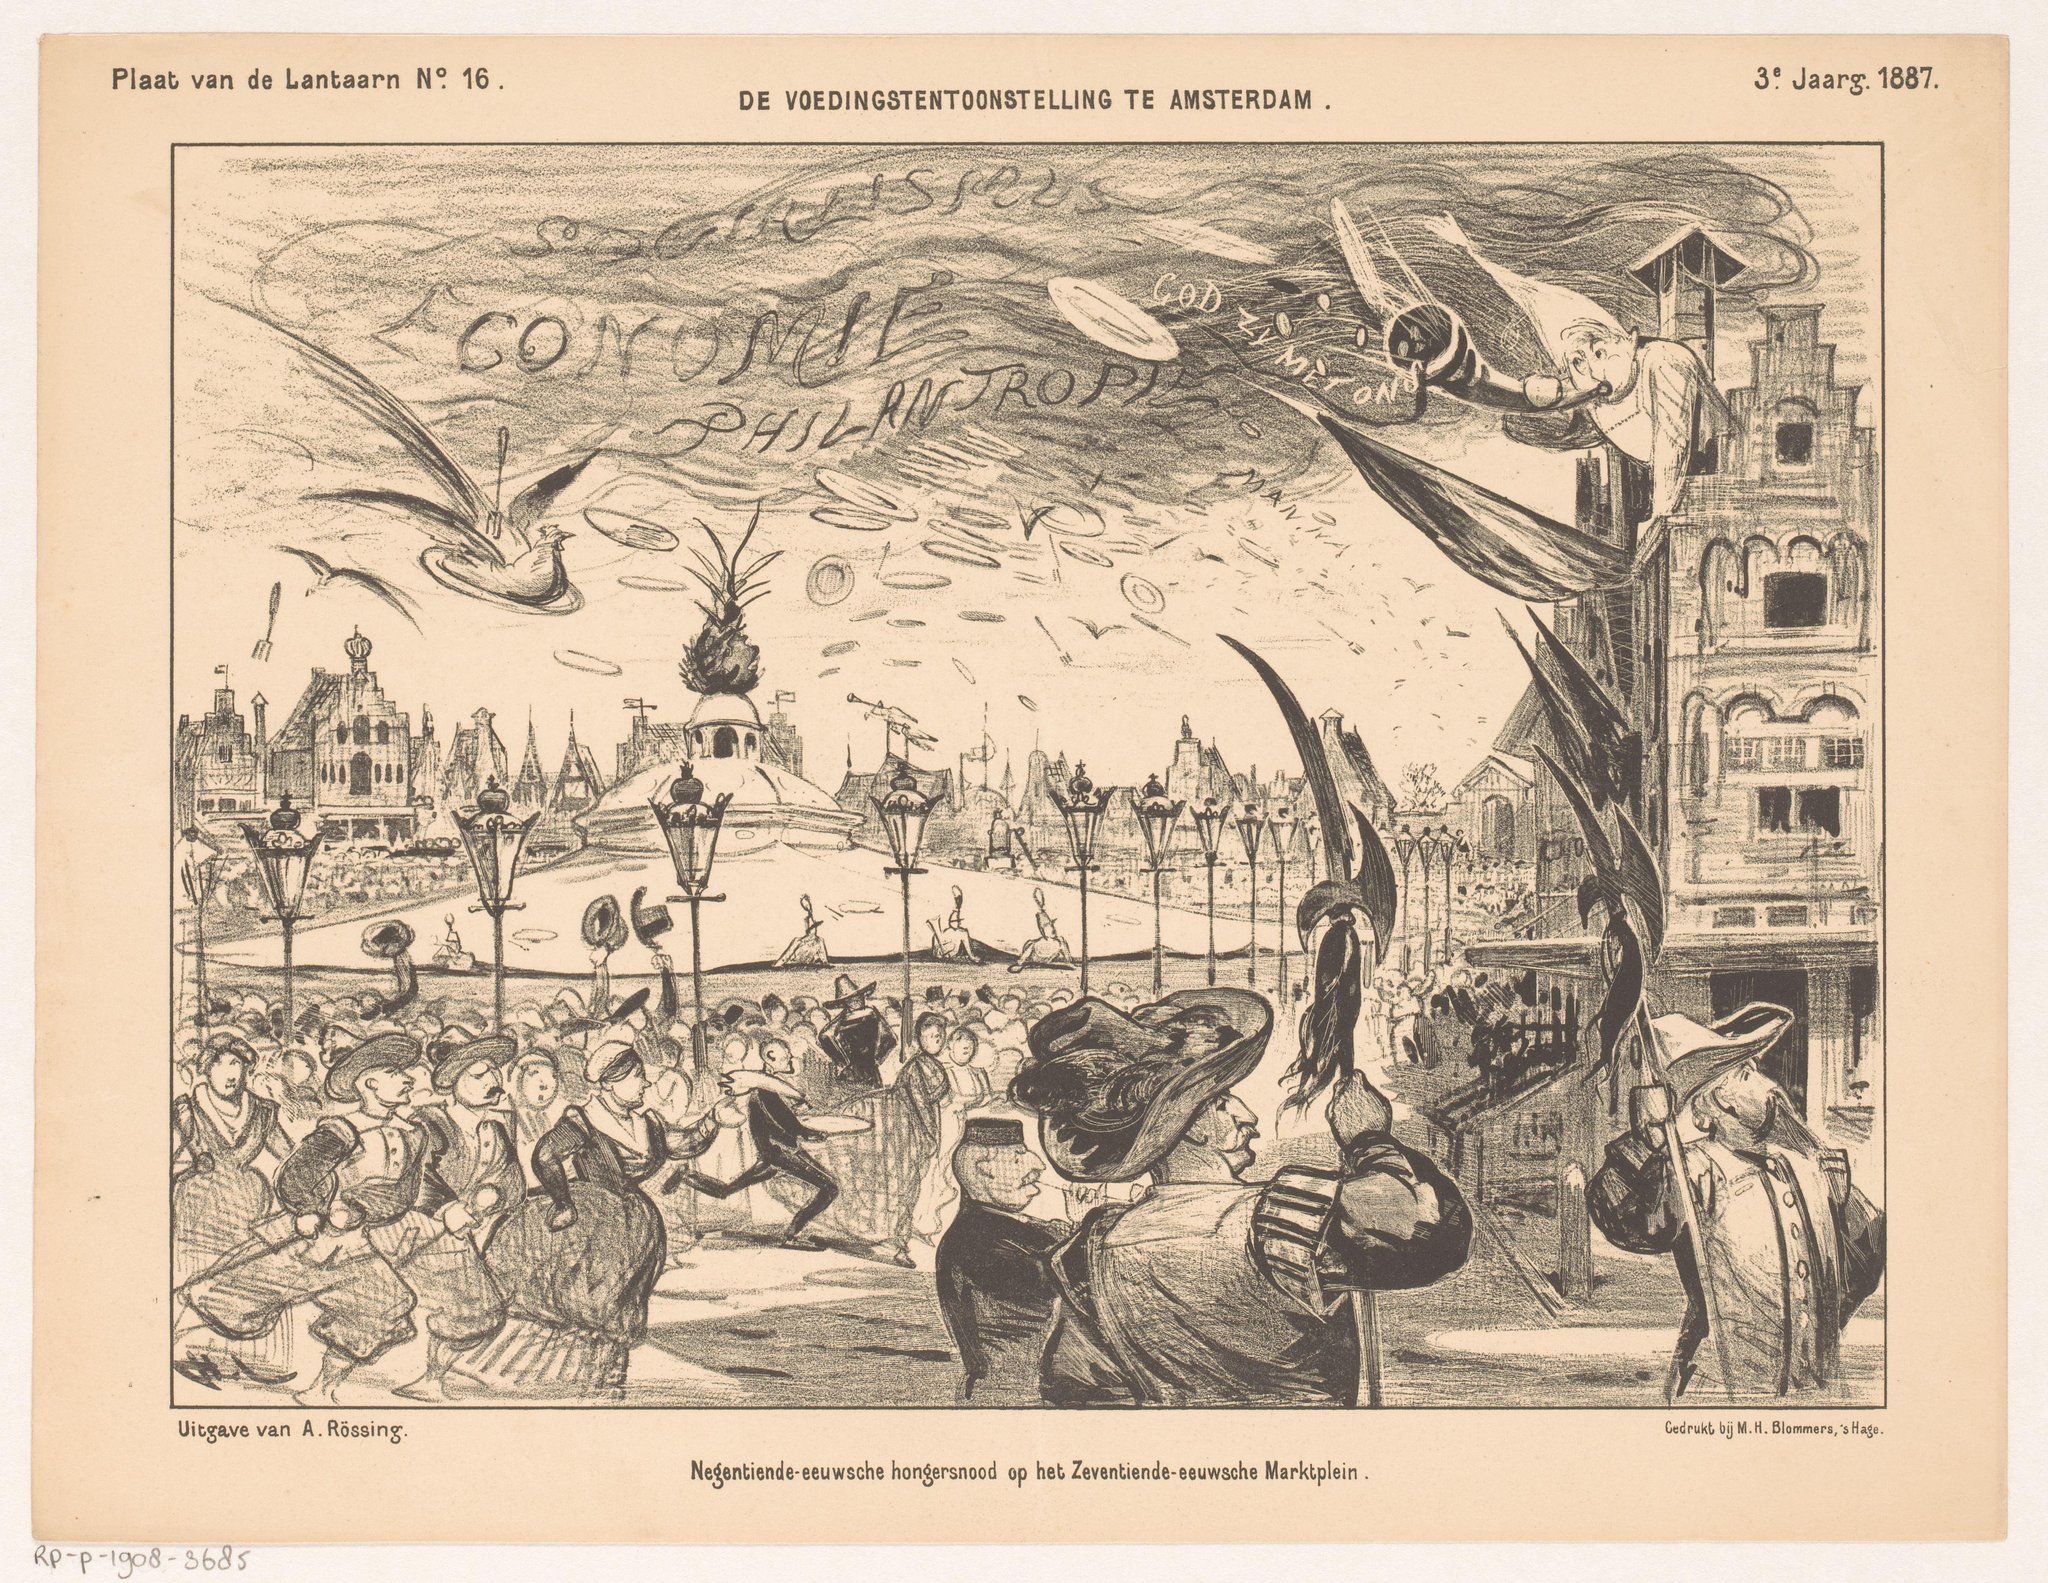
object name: cartoon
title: De voedingstentoonstelling te Amsterdam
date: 1887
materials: paper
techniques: lithograph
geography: netherlands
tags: tent, trade exhibition, industries fair, industries ~ food, drink, stimulants, political caricatures and satires, amsterdam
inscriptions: collector's mark: Lugt 2228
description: In het midden van een plein ligt een in elkaar gezakte tent. Door de lucht vliegen borden, bestek en gerechten. In de zomer van 1887 werd in Amsterdam de Tentoonstelling van Voedingsmiddelen georganiseerd waarbij al het nieuws op het gebied van voeding werd gedemonstreerd. Deze prent werd uitgegeven bij De Lantaarn.